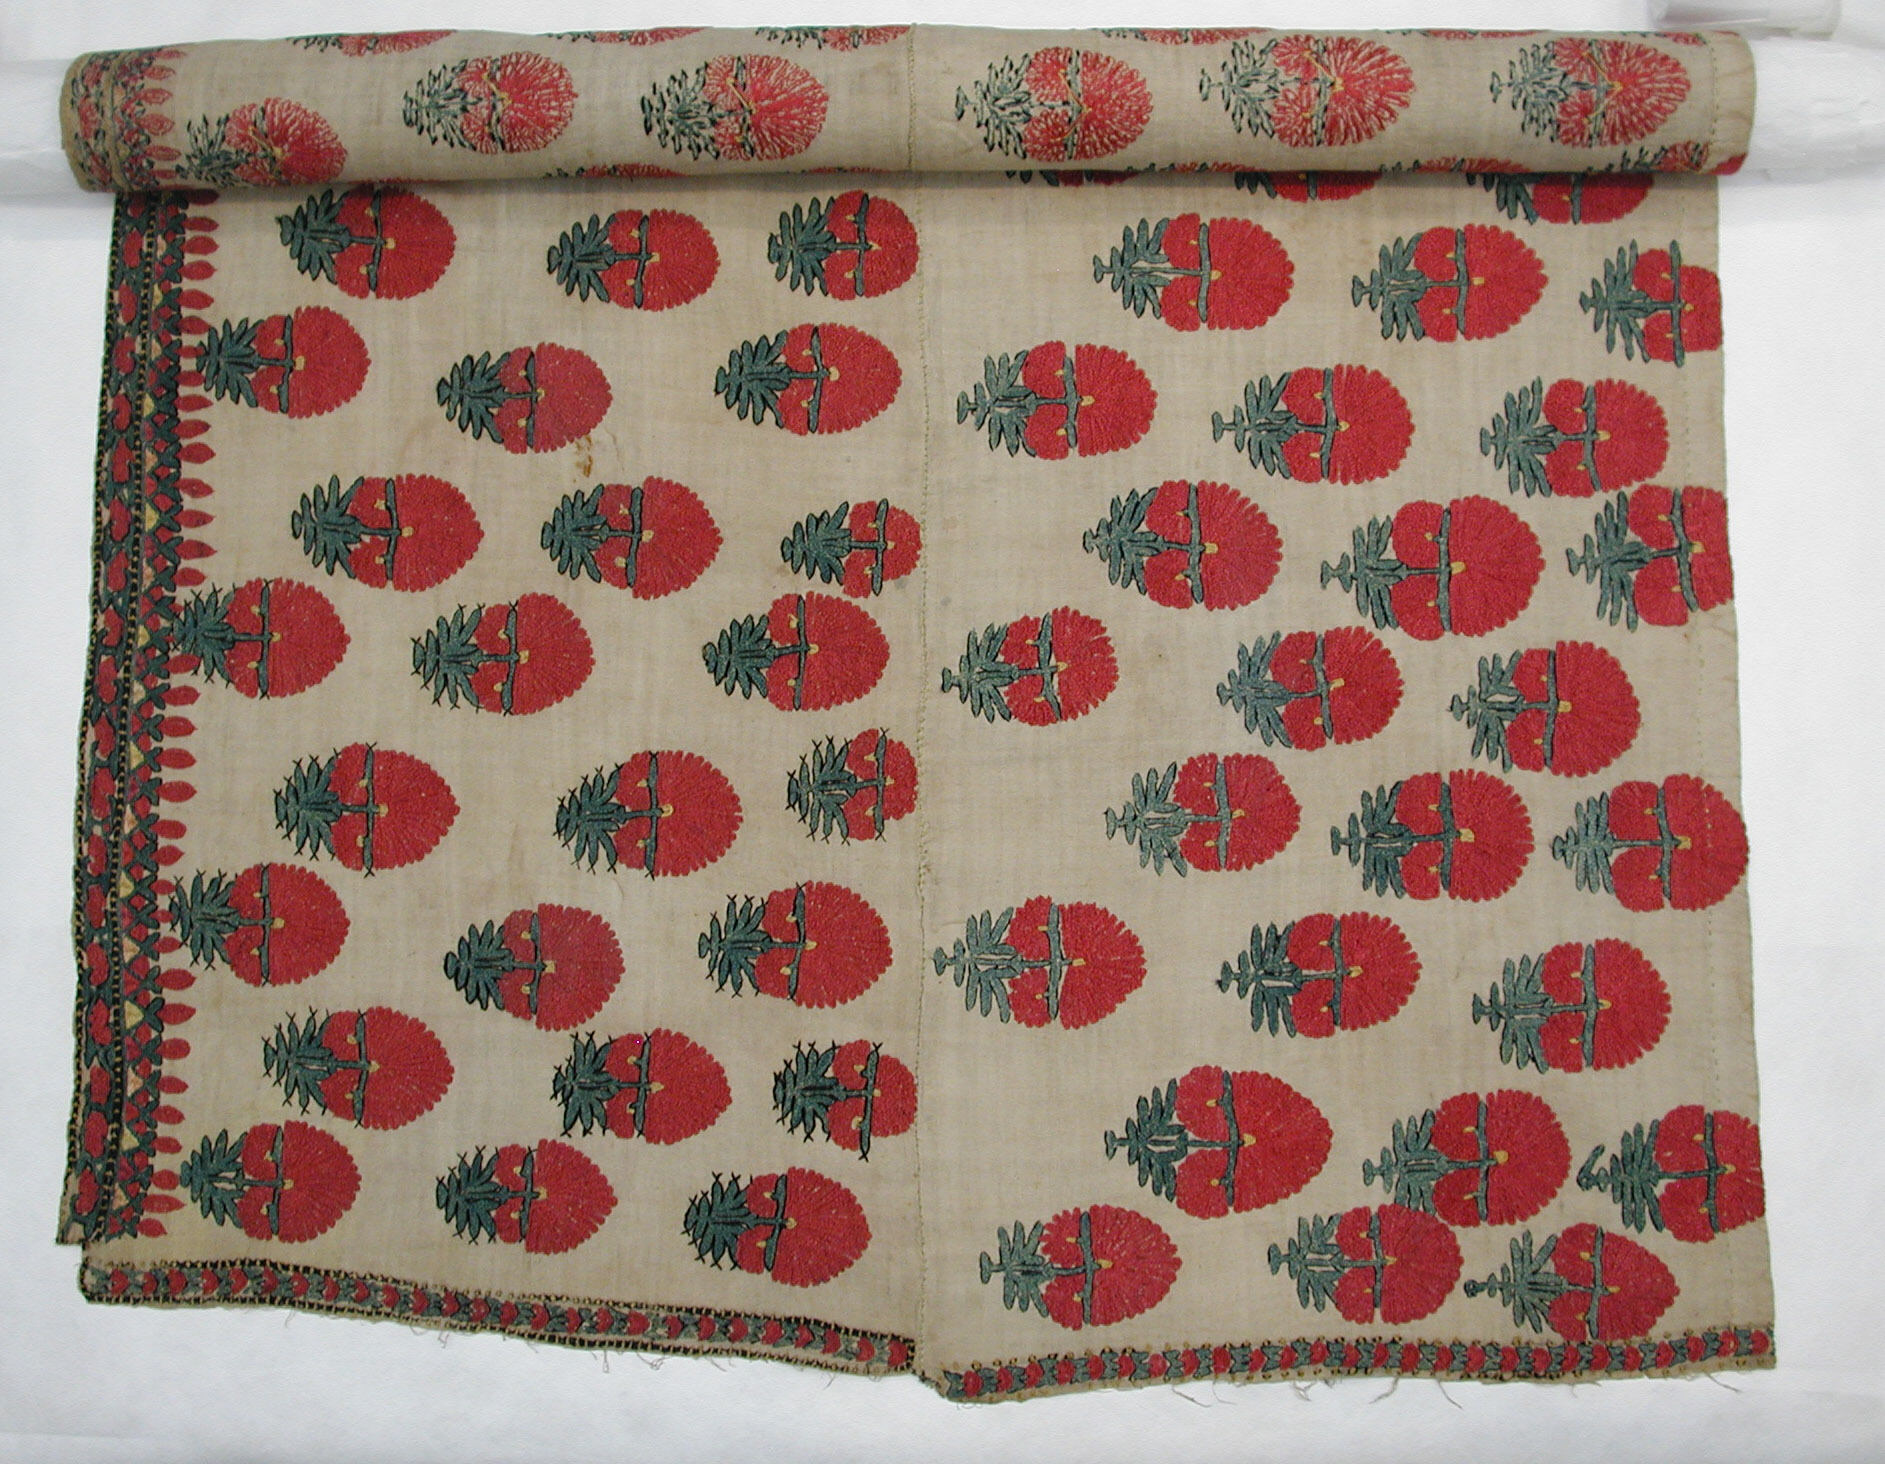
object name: hanging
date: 1701-1800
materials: linen, silk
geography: india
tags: trees